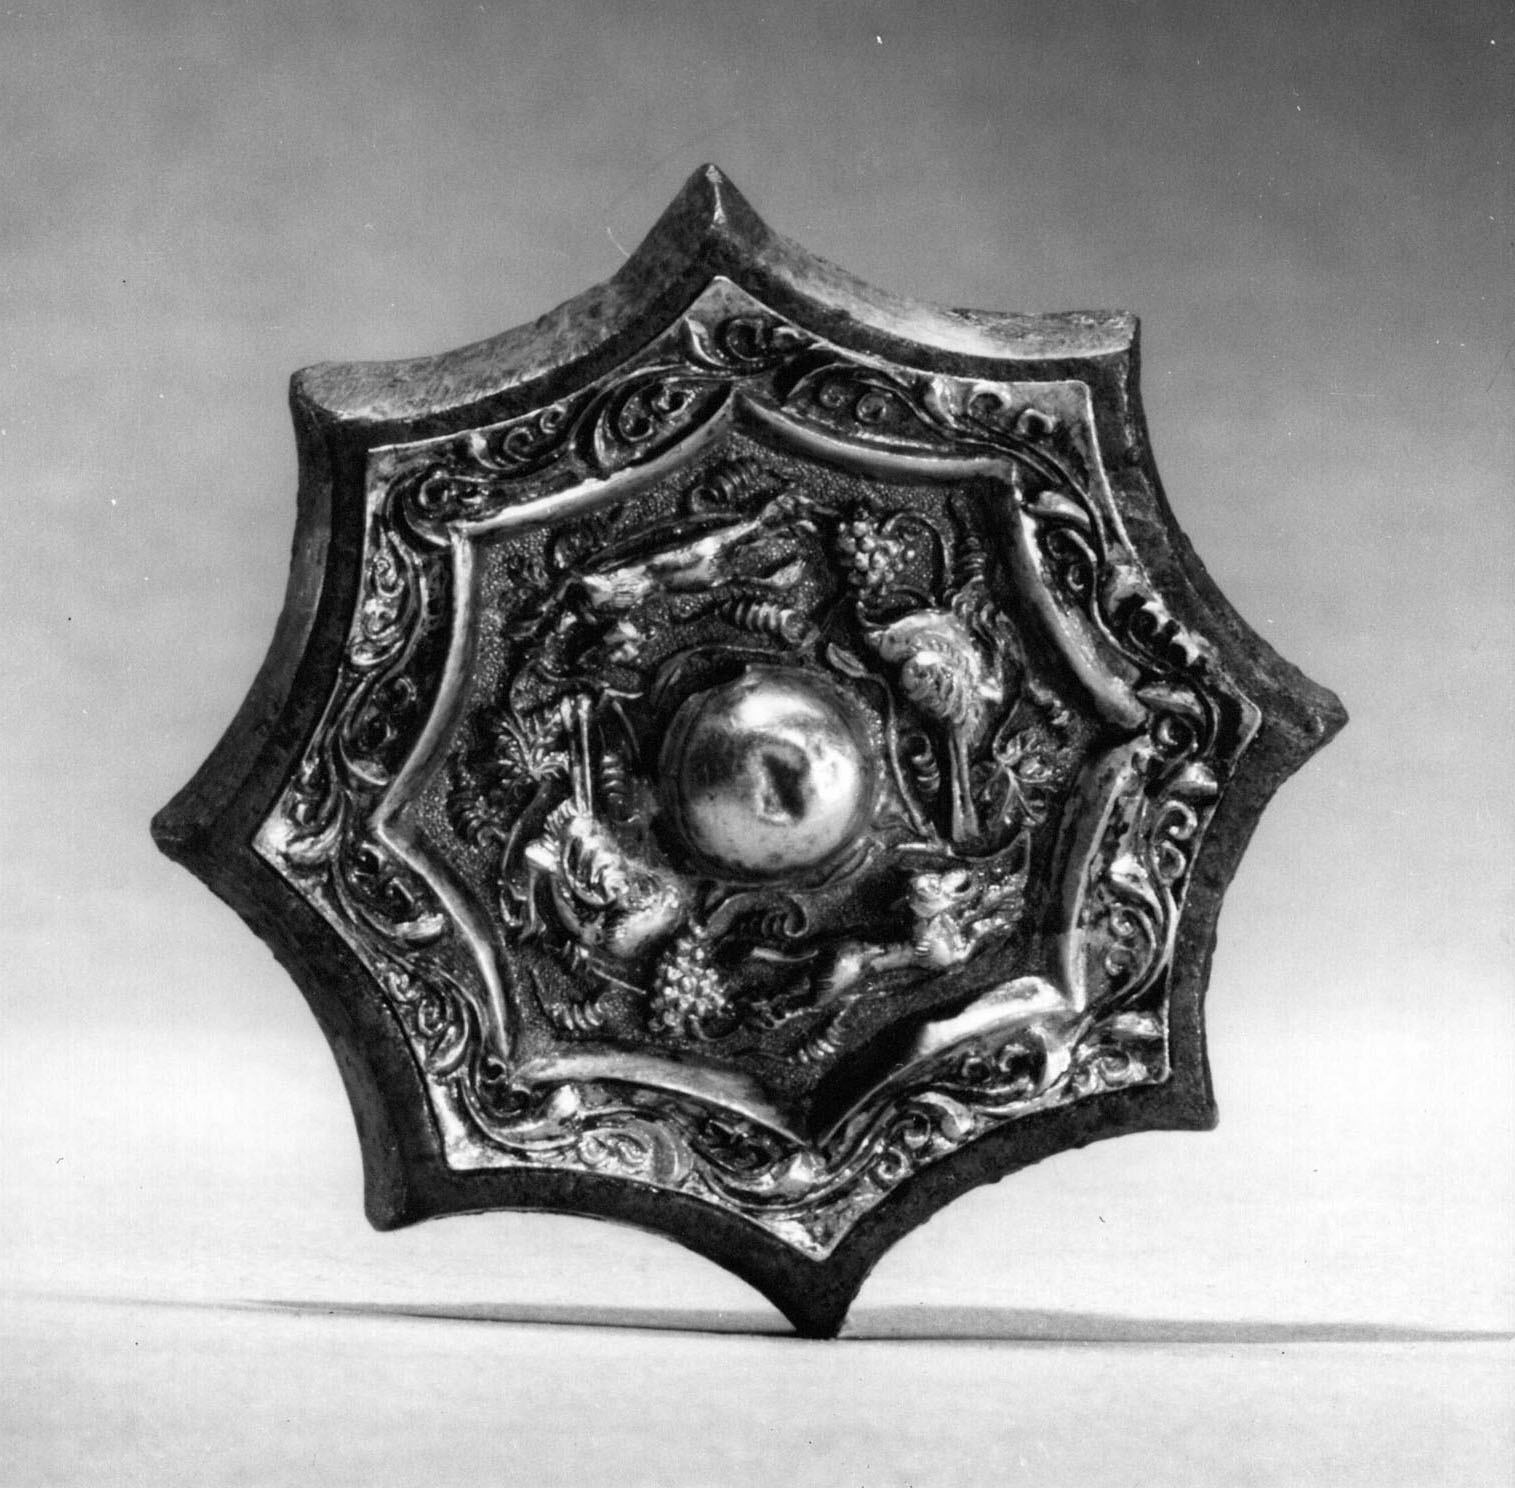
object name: mirror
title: Mirror in the shape of an eight-lobed flower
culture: chinese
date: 701-900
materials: bronze, gold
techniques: repoussé